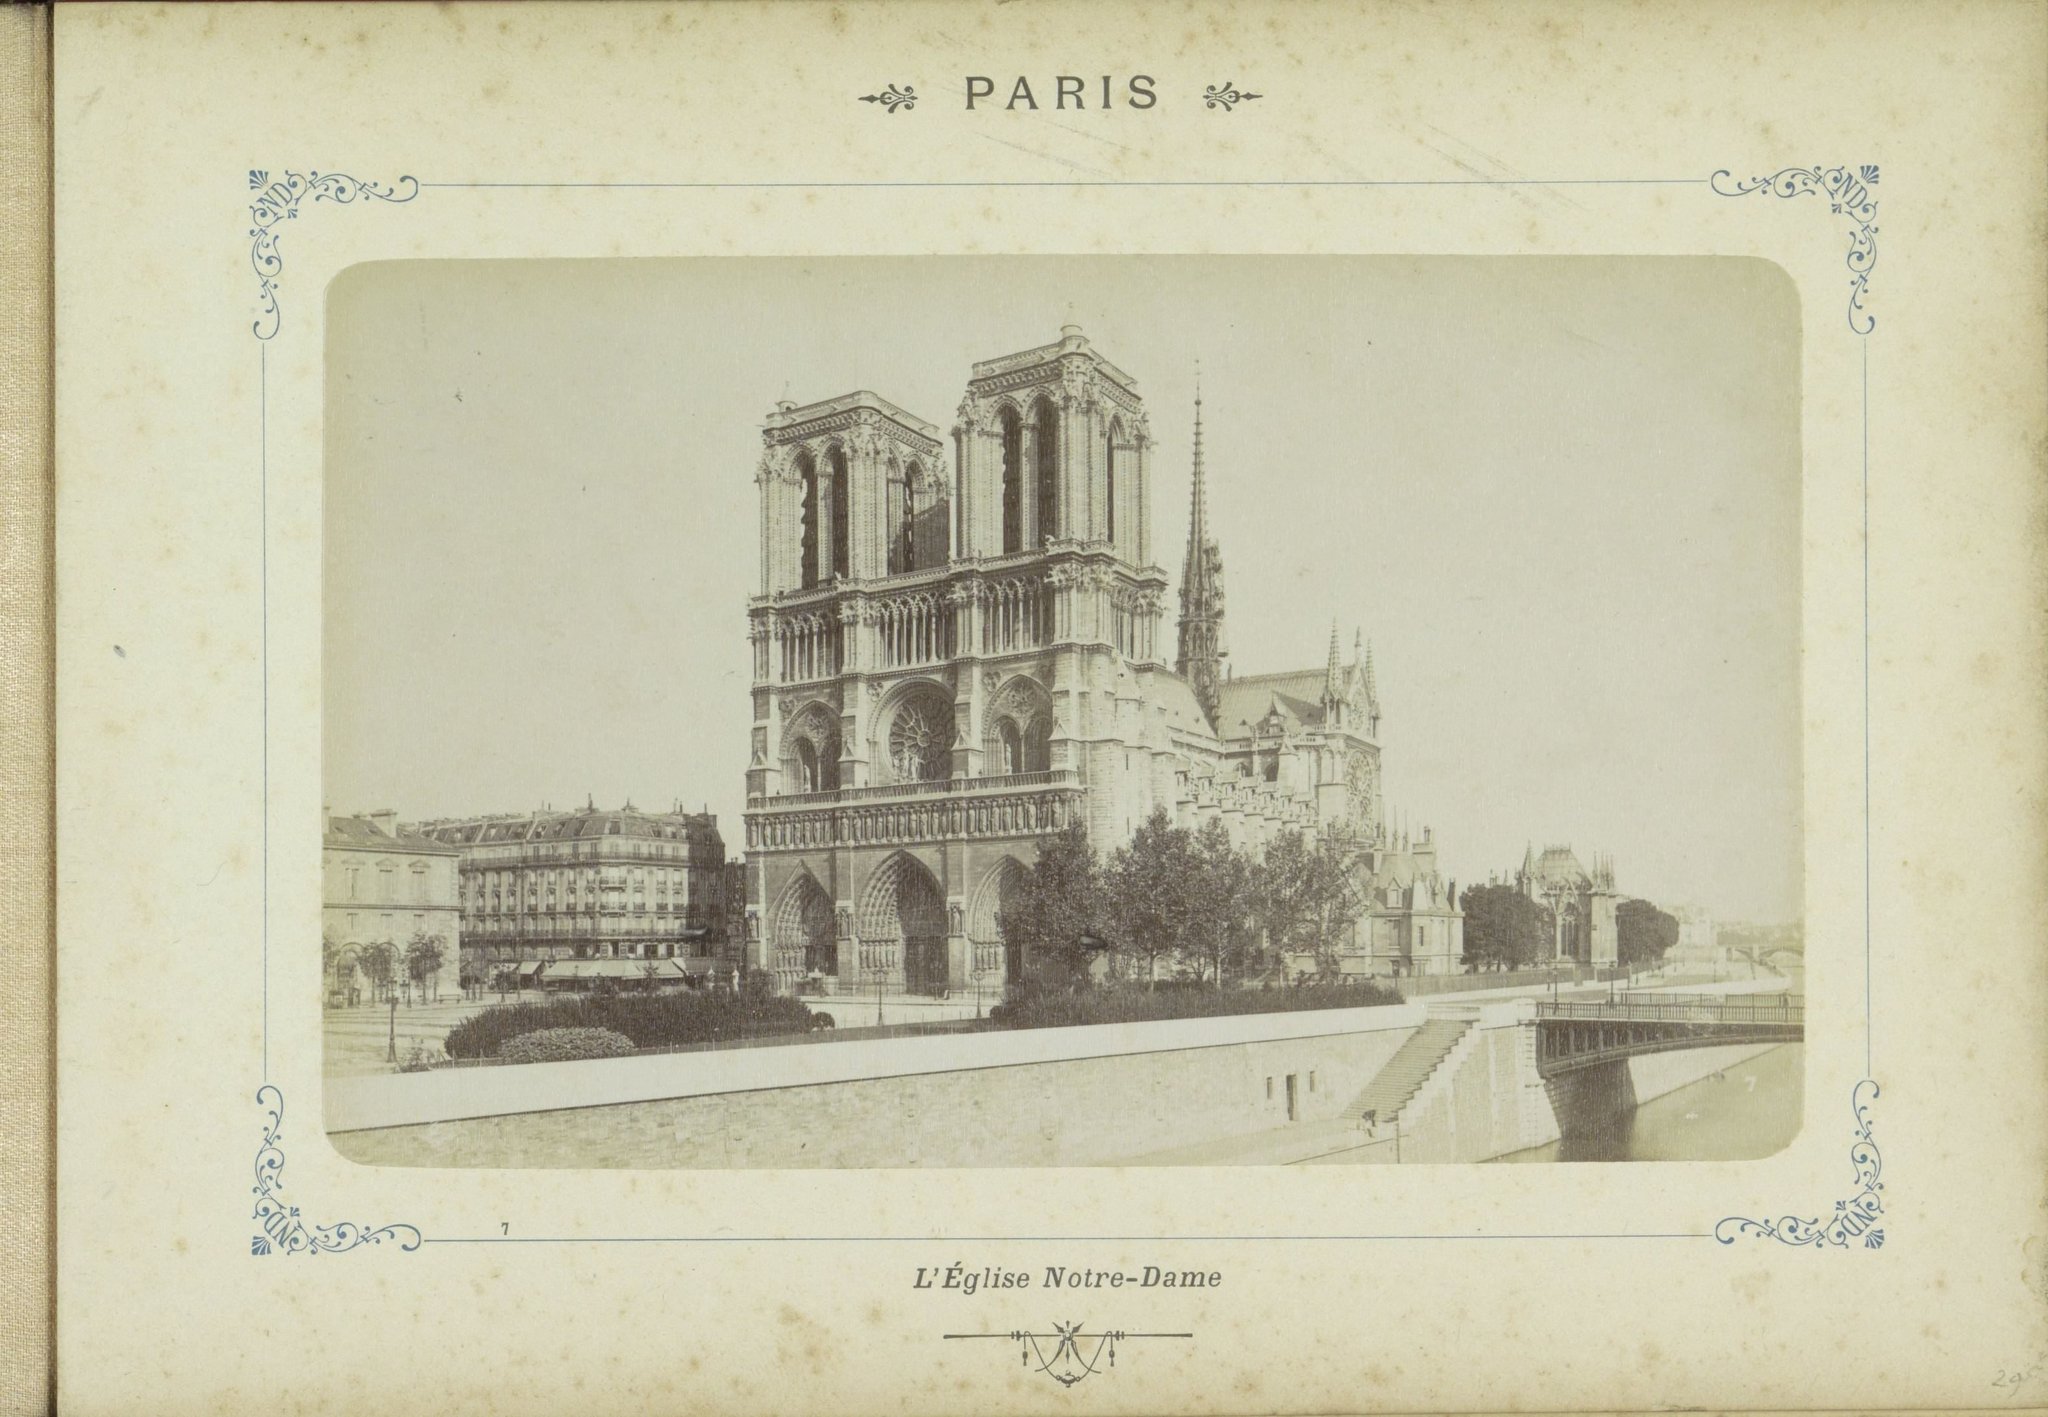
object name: photograph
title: Gezicht op de Notre-Dame in Parijs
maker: Anonymous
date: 1900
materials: cardboard, paper, photographic support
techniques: albumen print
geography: paris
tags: church (exterior), parts of church exterior and annexes: tower, paris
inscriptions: number: ‘7’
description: Onderdeel van Fotoalbum met bezienswaardigheden in Parijs, Versailles en het Bois de Boulogne.